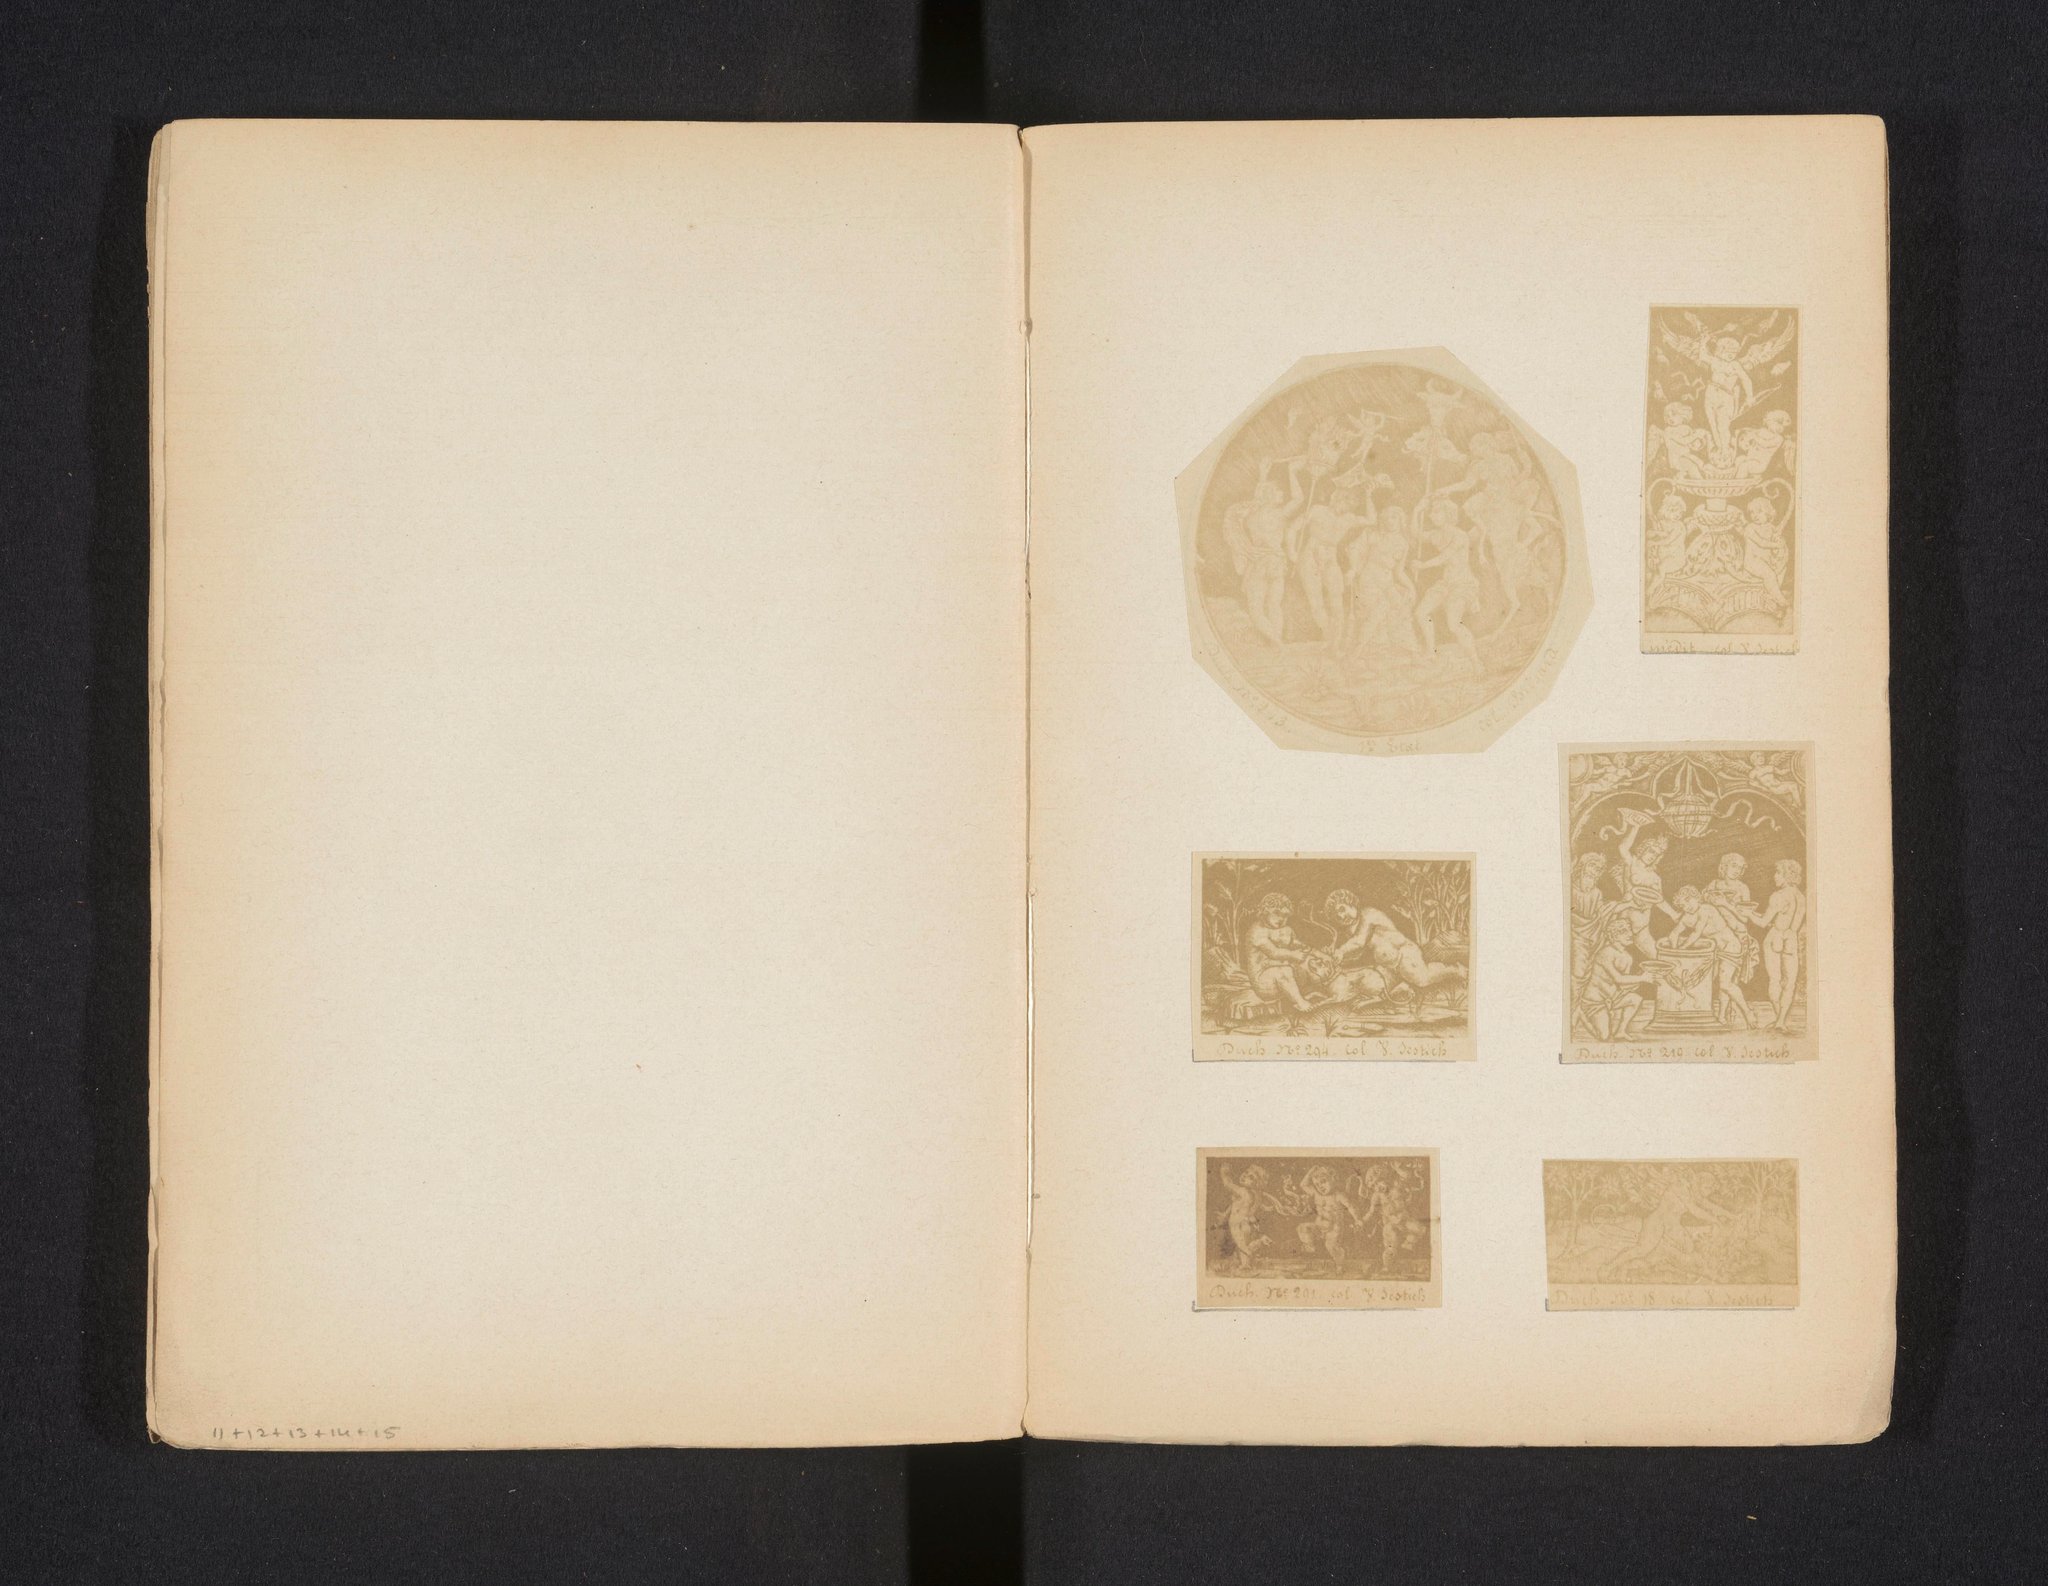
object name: photograph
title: Fotoreproductie van een prent van een bacchanaal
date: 1853-1858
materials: photographic support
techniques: salted paper print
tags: bacchanal: bacchus with his wine-flushed train (thiasos)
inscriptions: inscription: ‘Duch. No 219. col. V. Sestich’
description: Foto op zevende ongenummerde pagina na pagina 142.